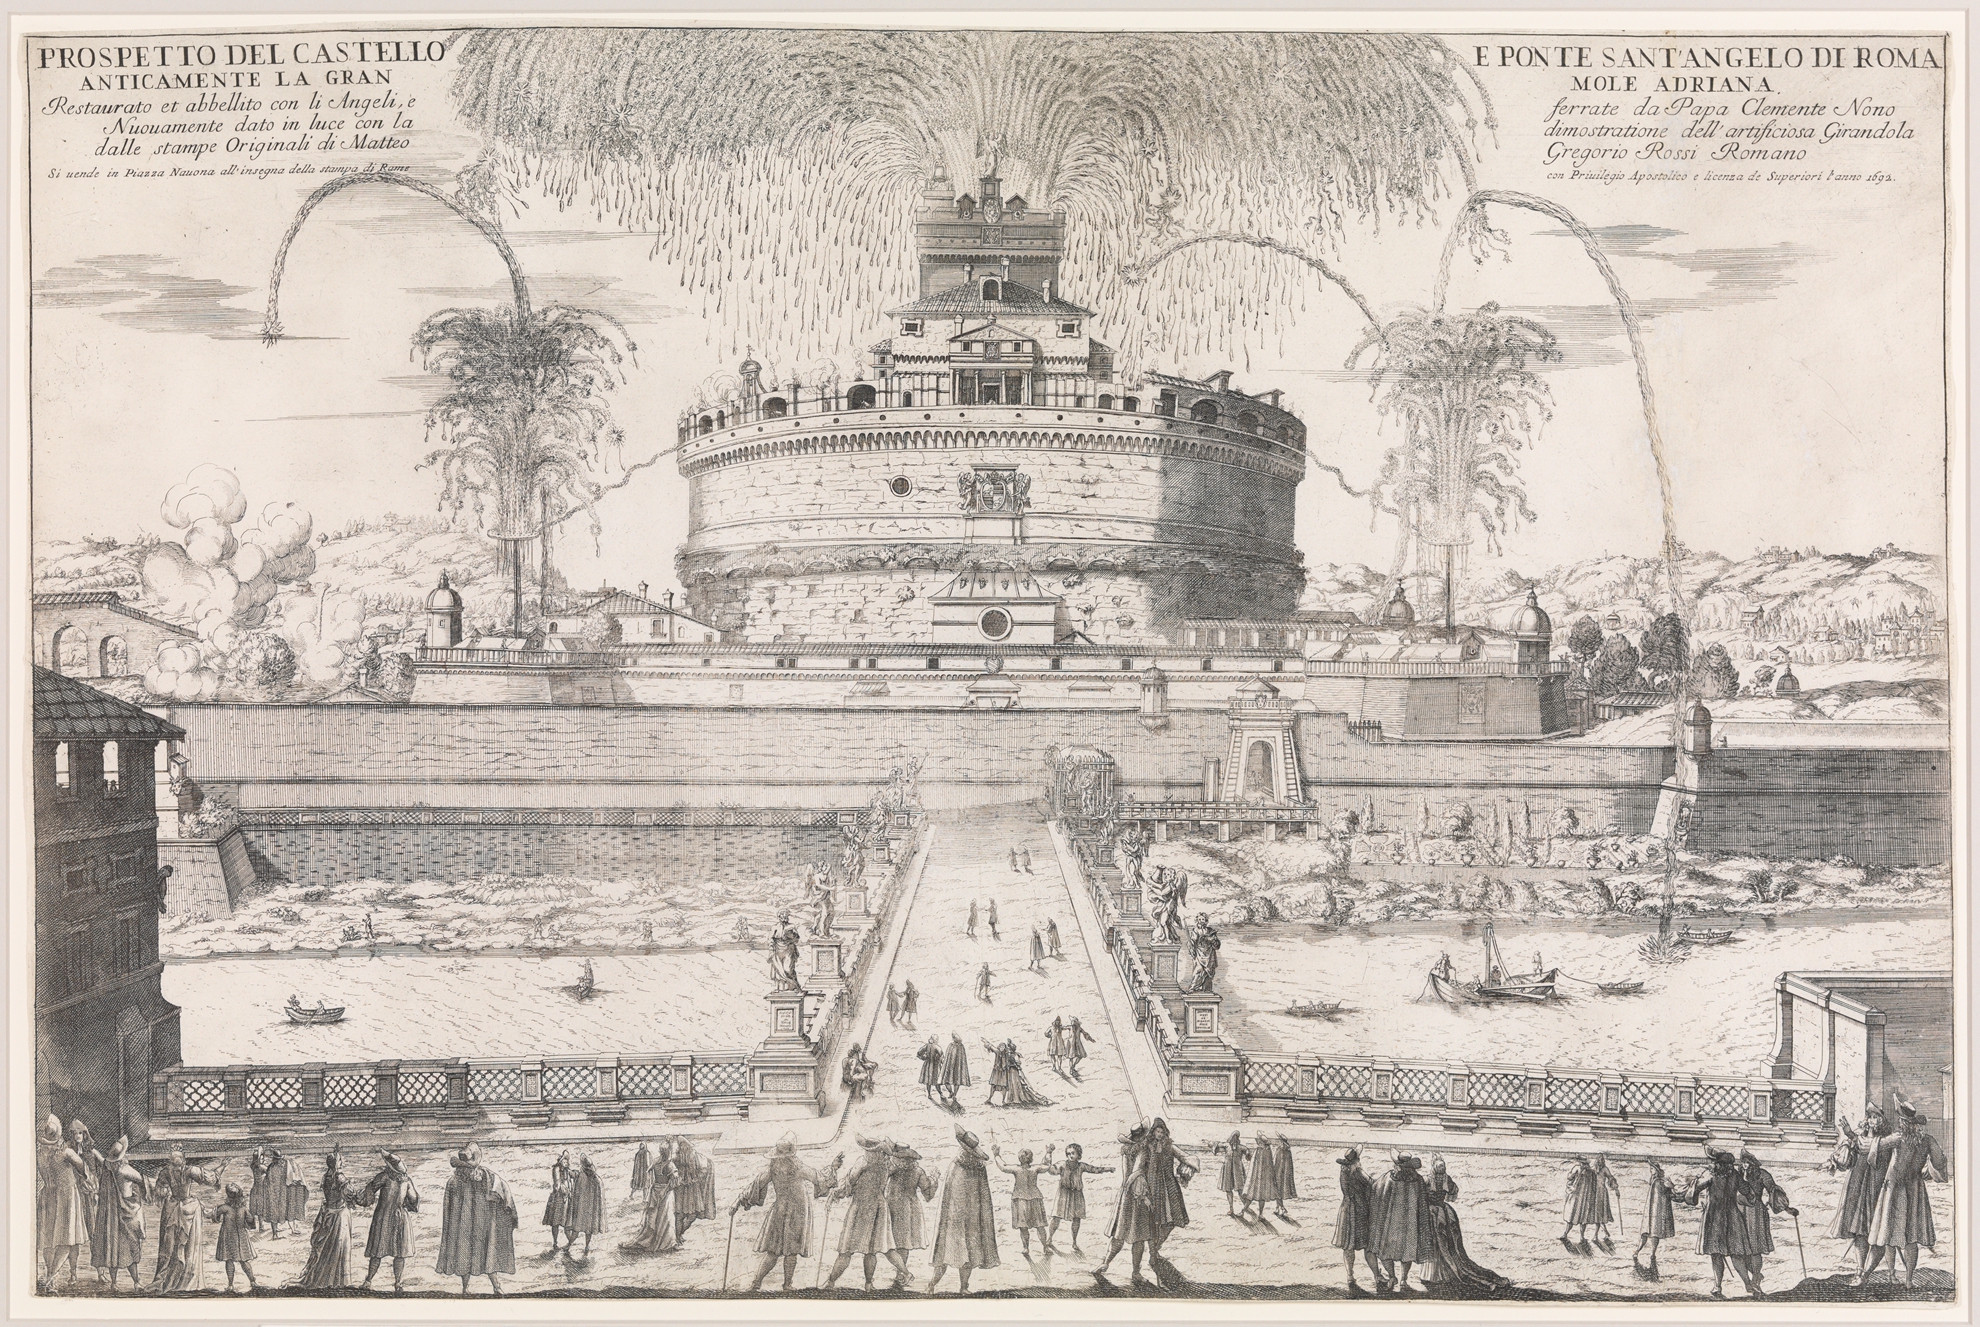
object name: print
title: The Girandola at the Castel Sant'Angelo, Rome, 1692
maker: giovanni battista falda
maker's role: artist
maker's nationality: italian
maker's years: 1643-1678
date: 1692-1702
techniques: etching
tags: human figures,castles,bridges,fireworks,boats,rome